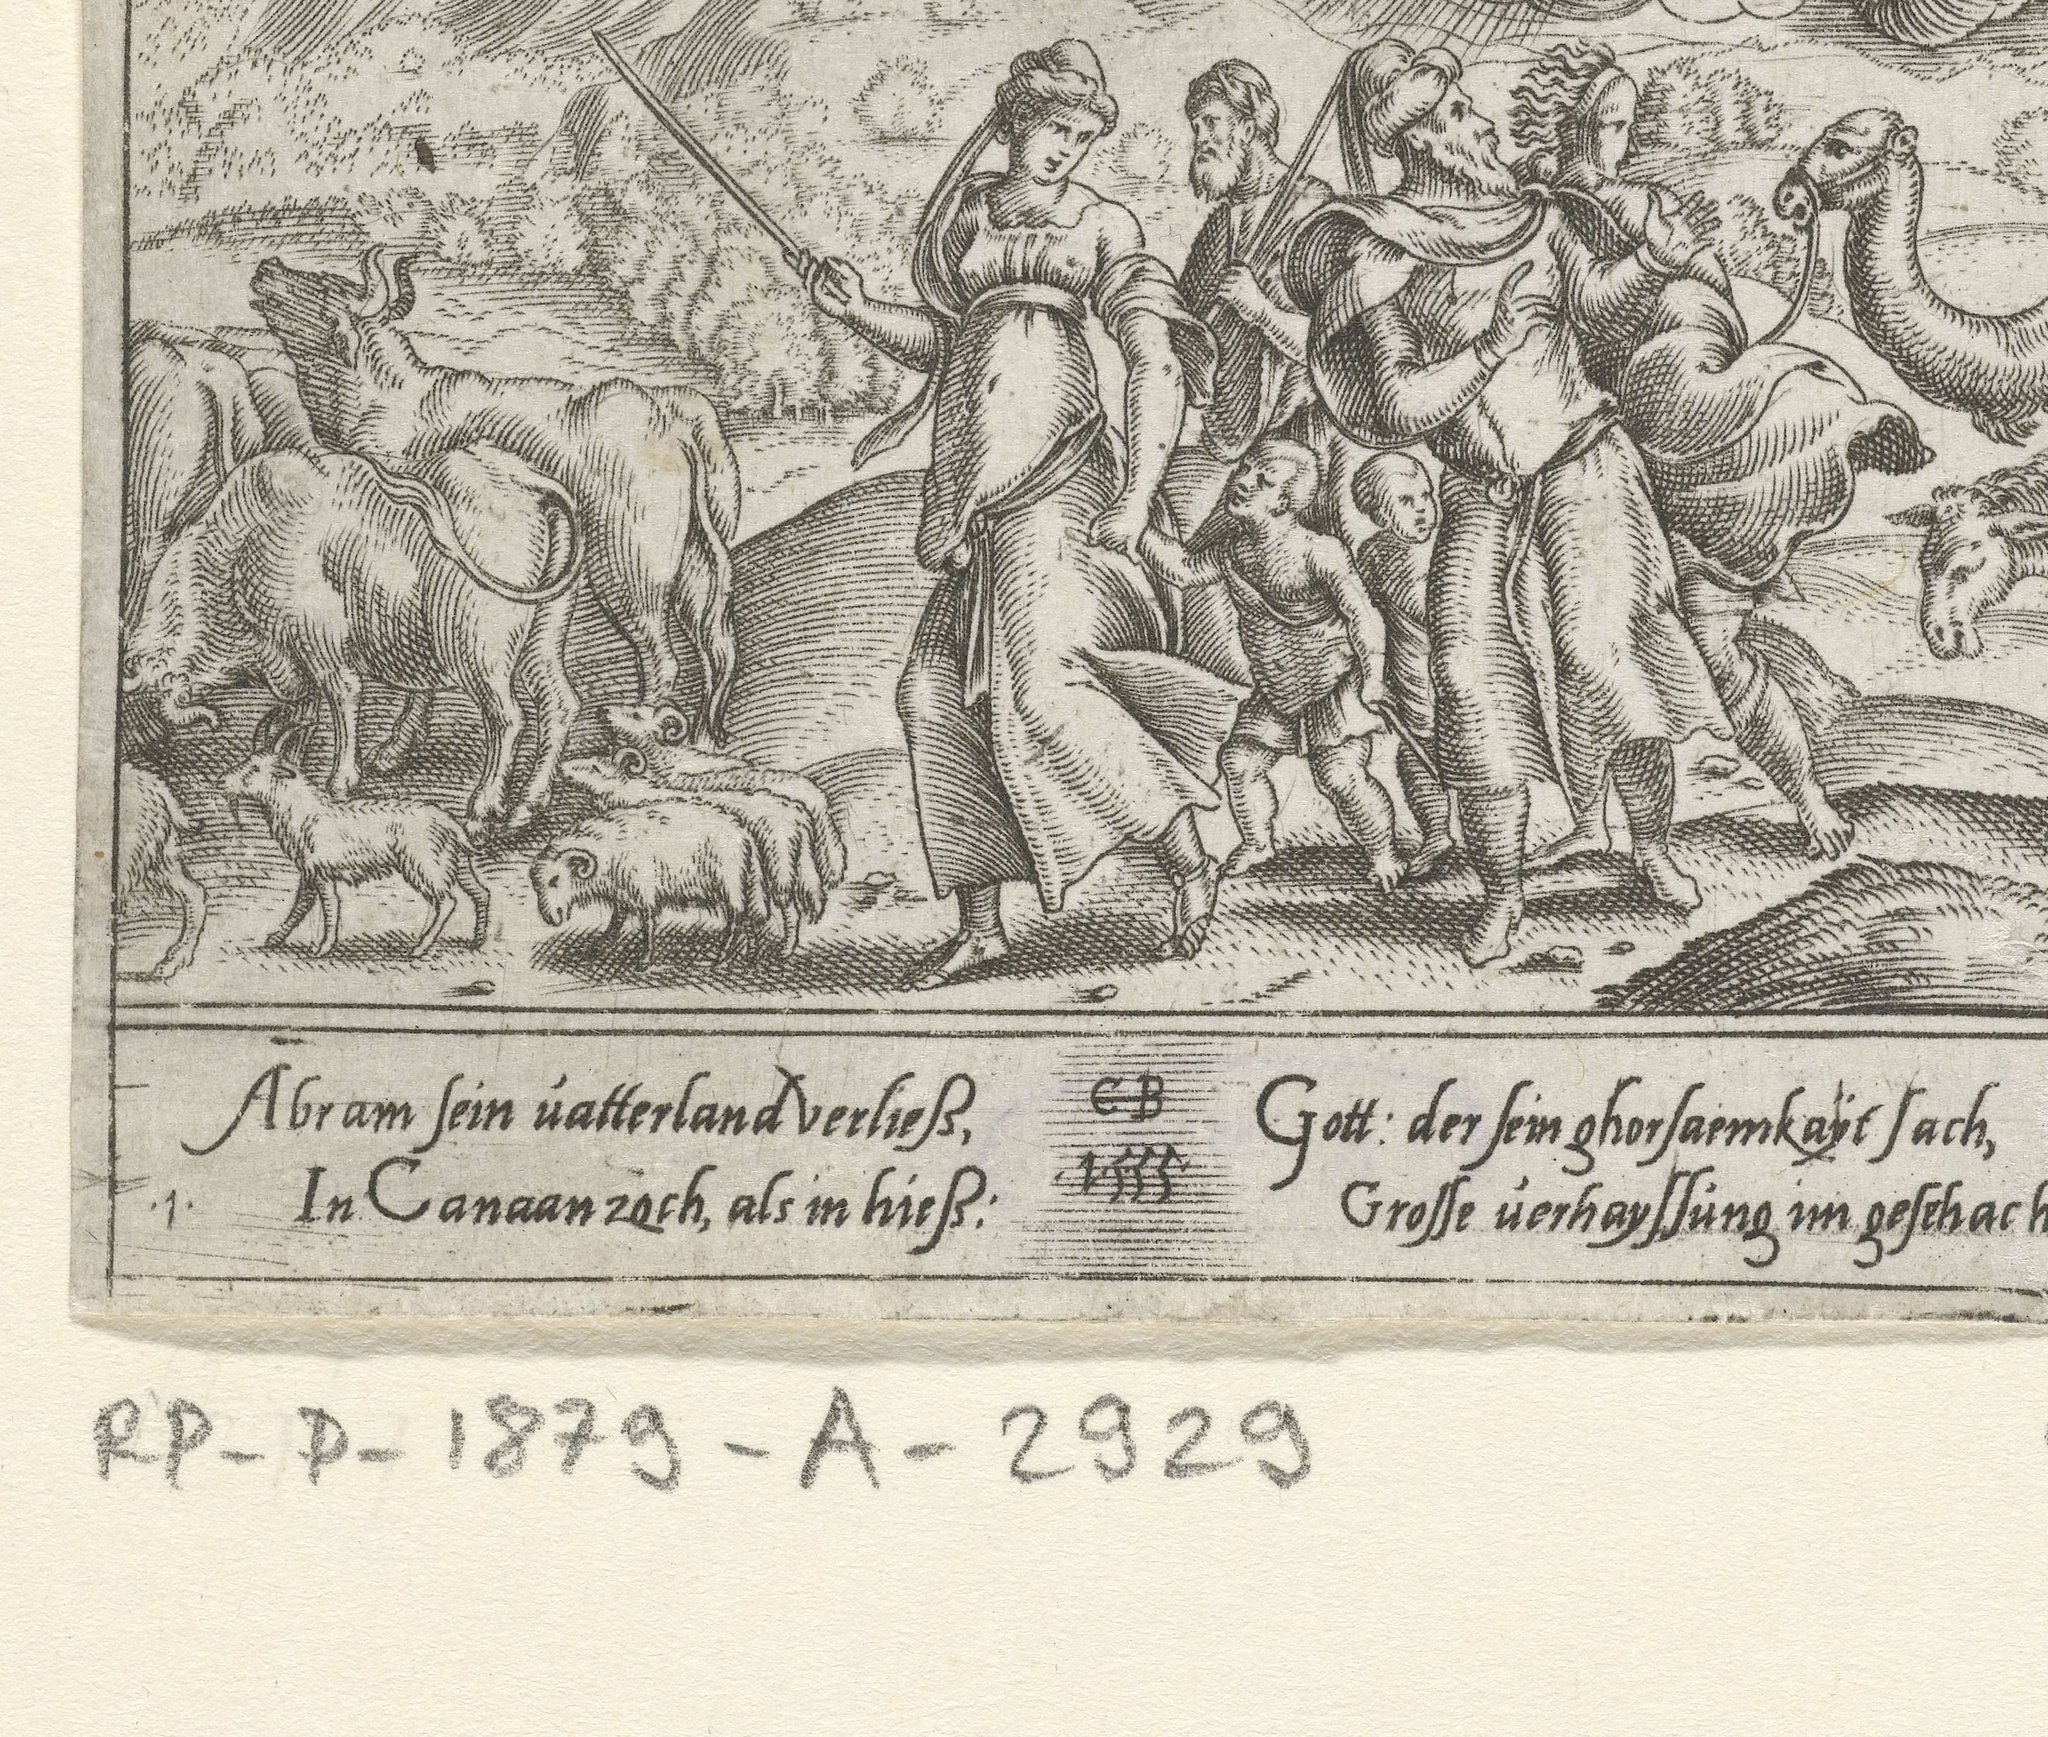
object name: print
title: Het leven van Abraham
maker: cornelis bos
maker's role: print maker, printer, publisher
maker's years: 1510-1566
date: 1555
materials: paper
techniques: engraving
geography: groningen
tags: abraham goes to canaan (genesis 12:1-9)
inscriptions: collector's mark: Lugt 2228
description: God wijst Abraham de weg naar Kanaän. Abraham trekt met zijn familie en zijn dieren naar het hem onbekende land. Prent uit een serie van 12 prenten met het leven van Abraham. Alle prenten hebben vier regels Duitse verklarende tekst in de ondermarge.